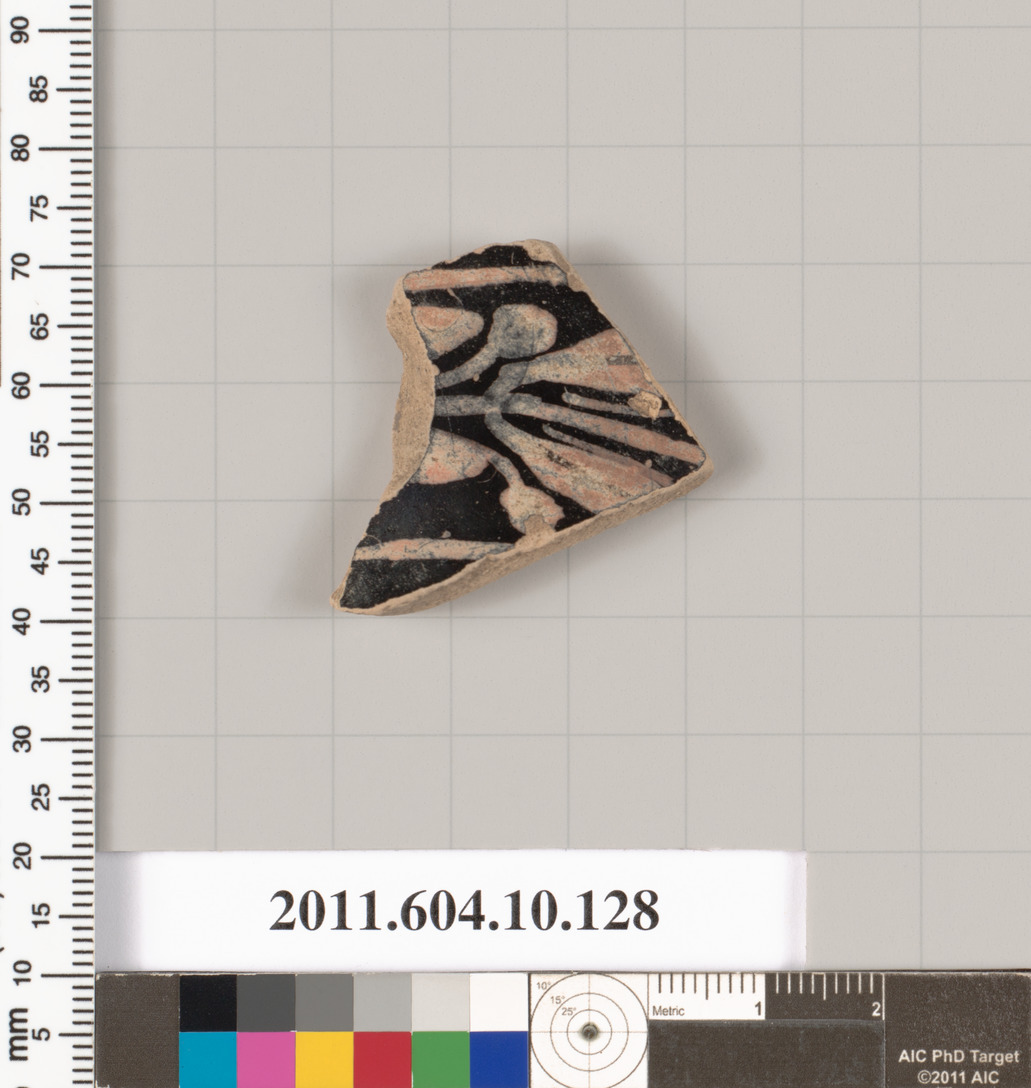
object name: oinochoe fragment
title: Terracotta fragment of an oinochoe (jug)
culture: etruscan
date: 434-368 BCE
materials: terracotta